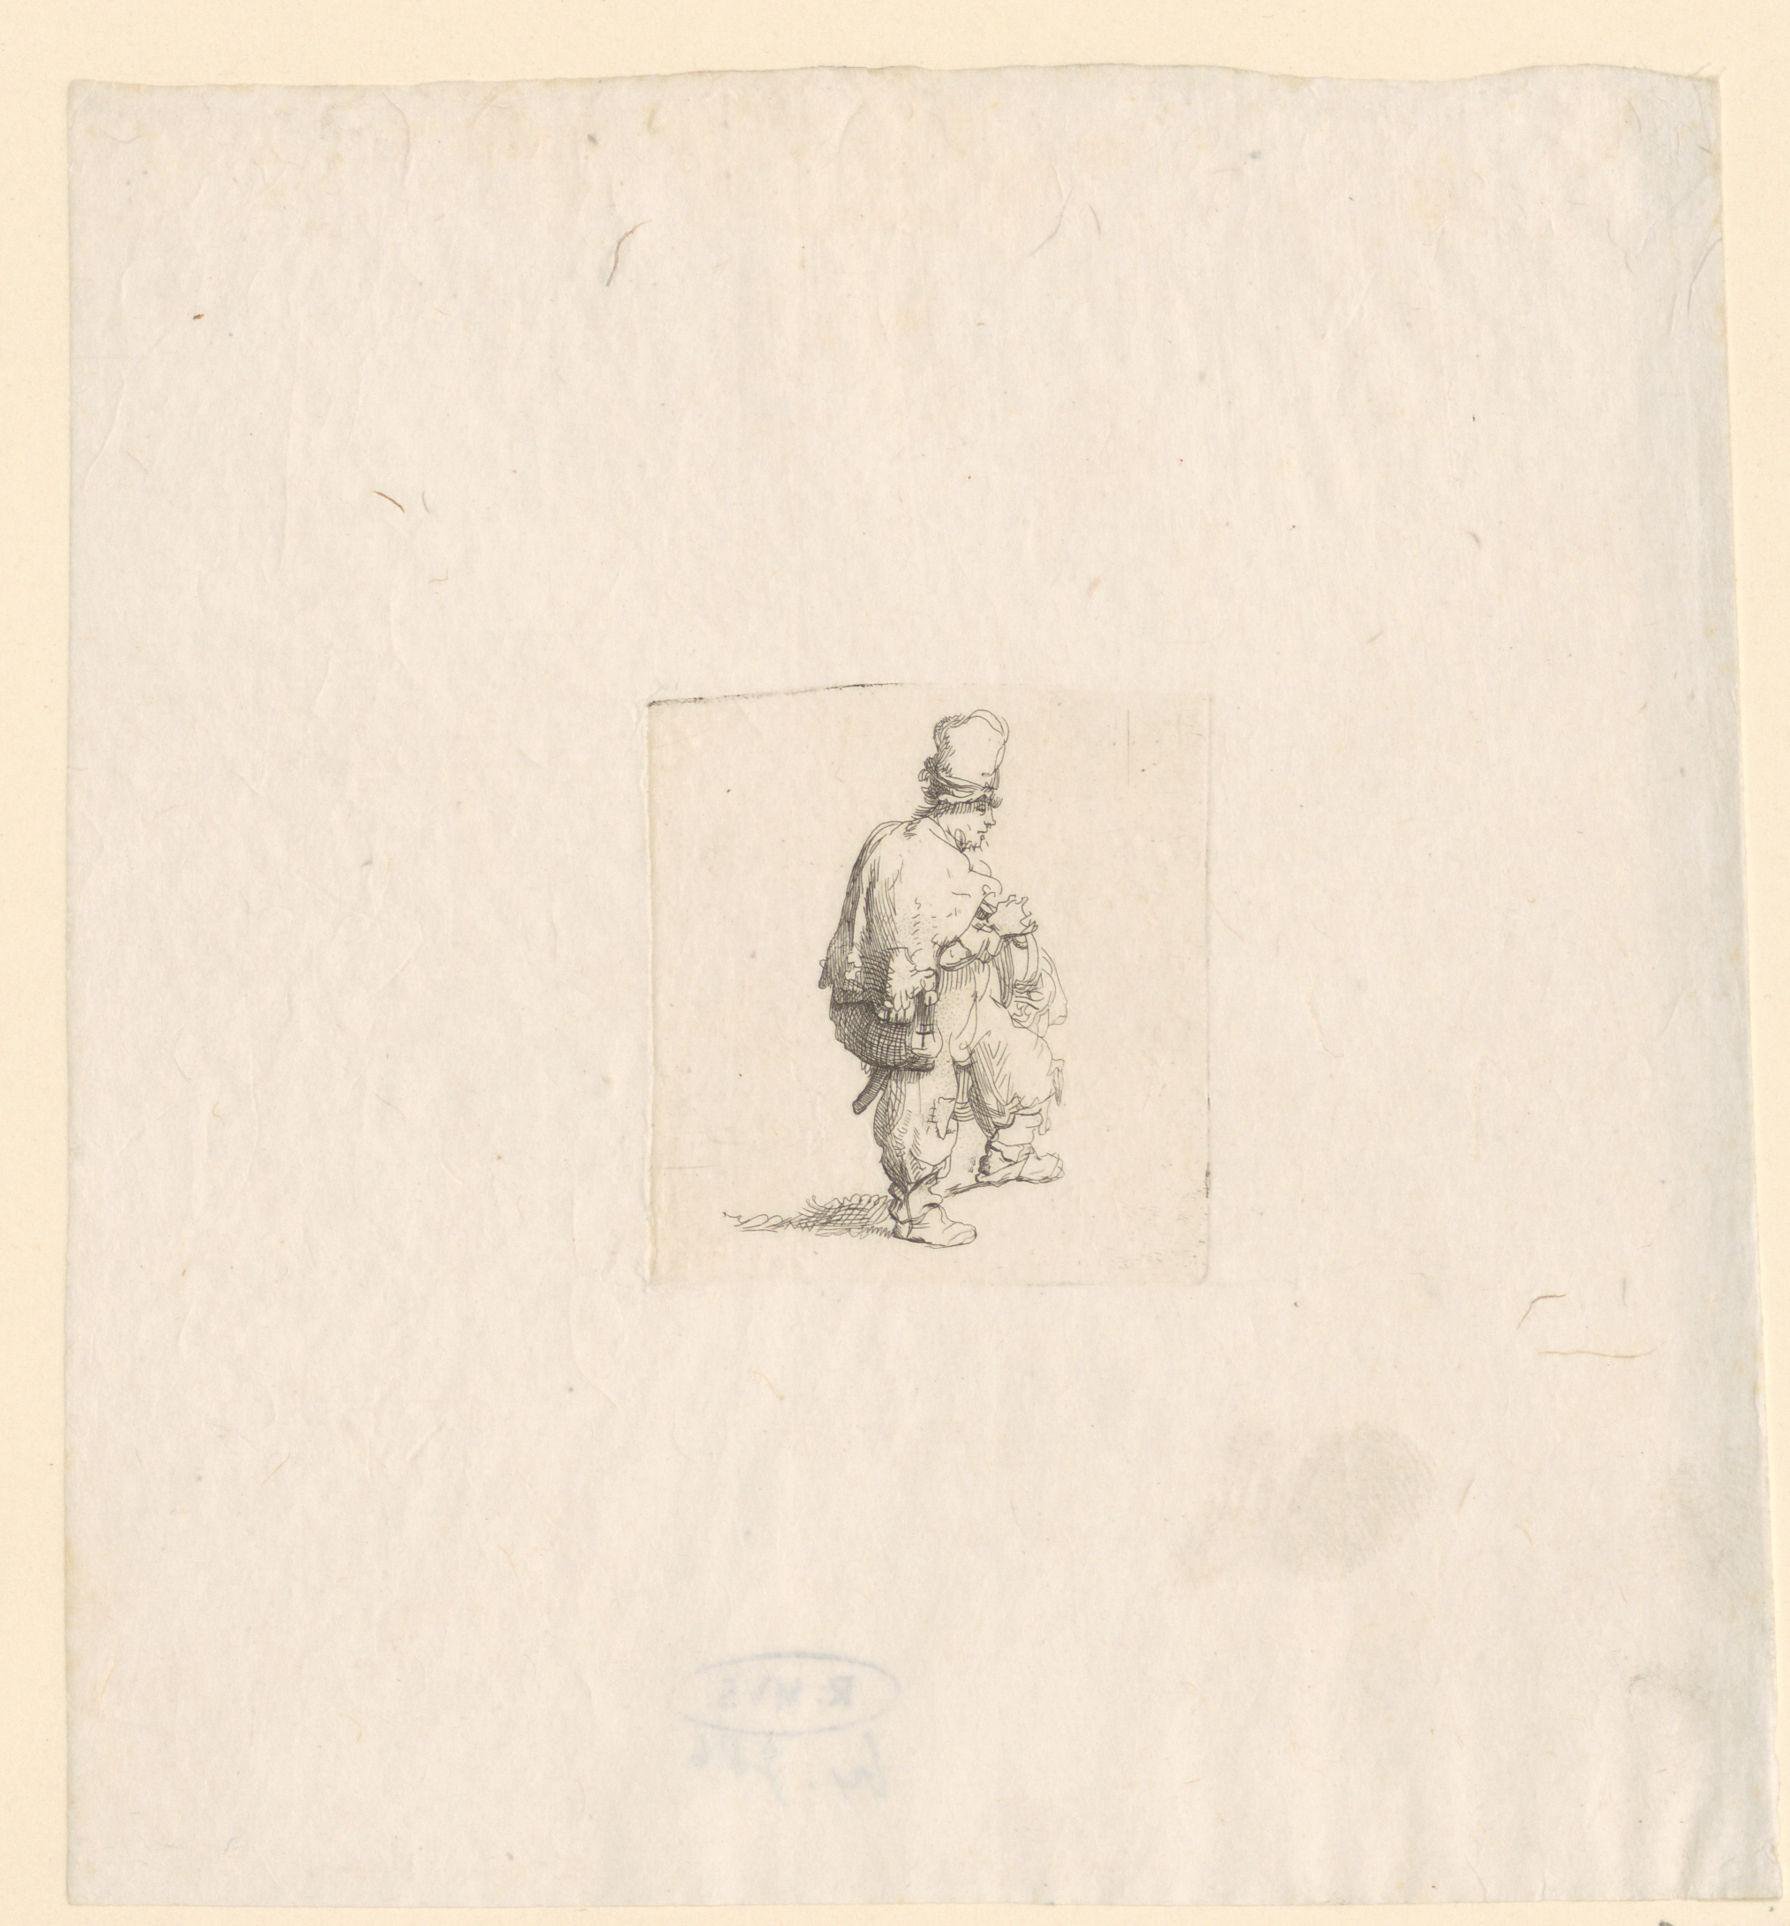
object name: print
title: Twaalf etsen naar Rembrandt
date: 1824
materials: paper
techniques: etching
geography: london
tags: hurdy-gurdy player - cc - out of doors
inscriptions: collector's mark: Lugt 2228